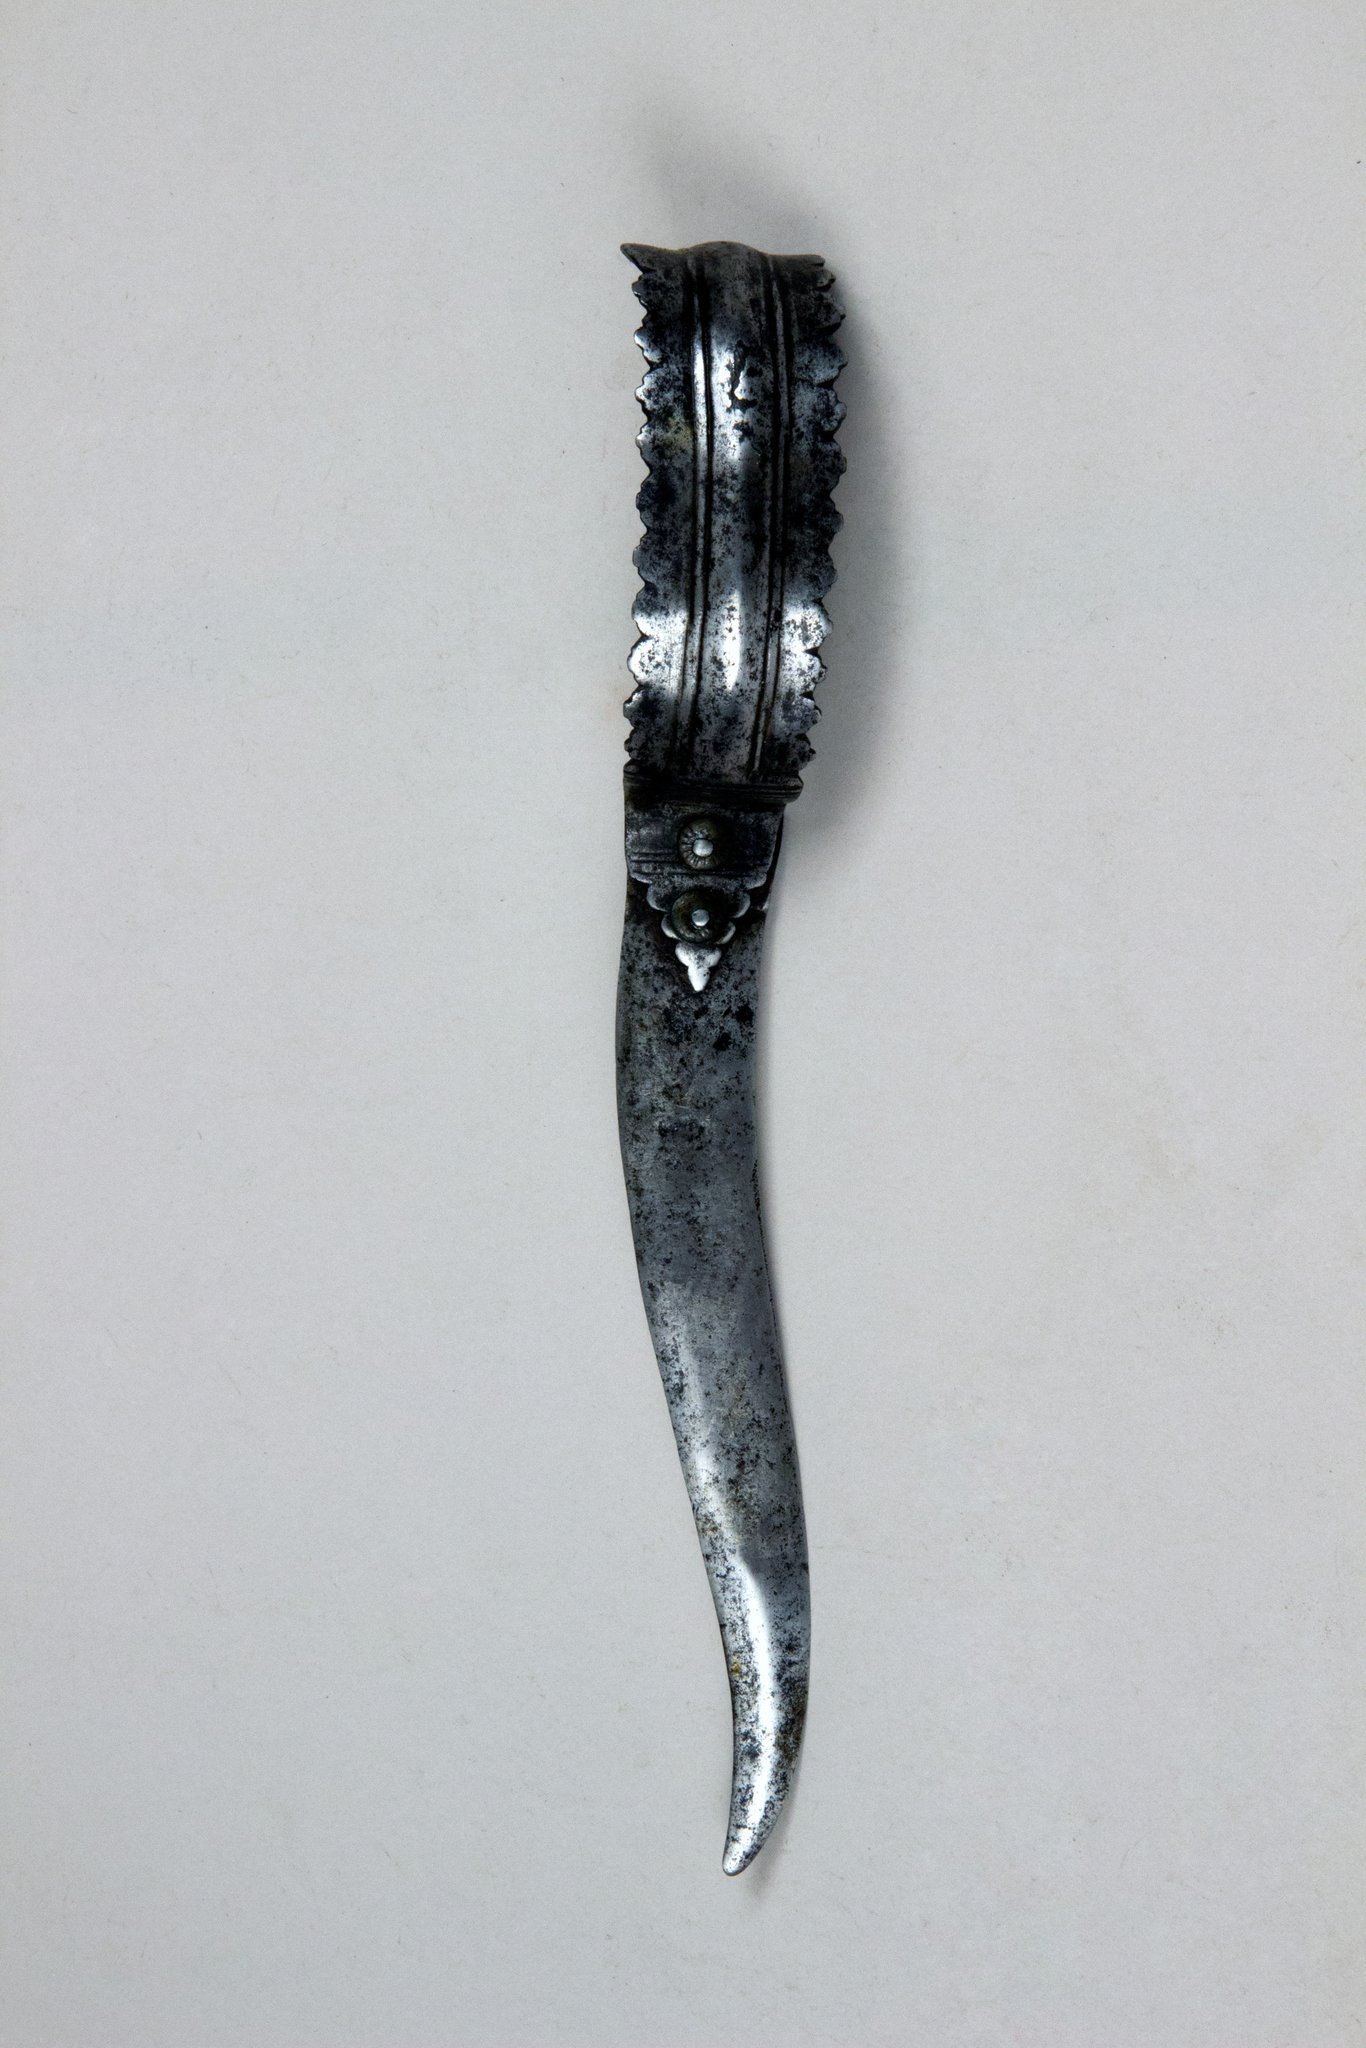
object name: dagger bichuwa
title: Dagger (Bichuwa)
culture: indian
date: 1601-1800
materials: steel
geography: central india